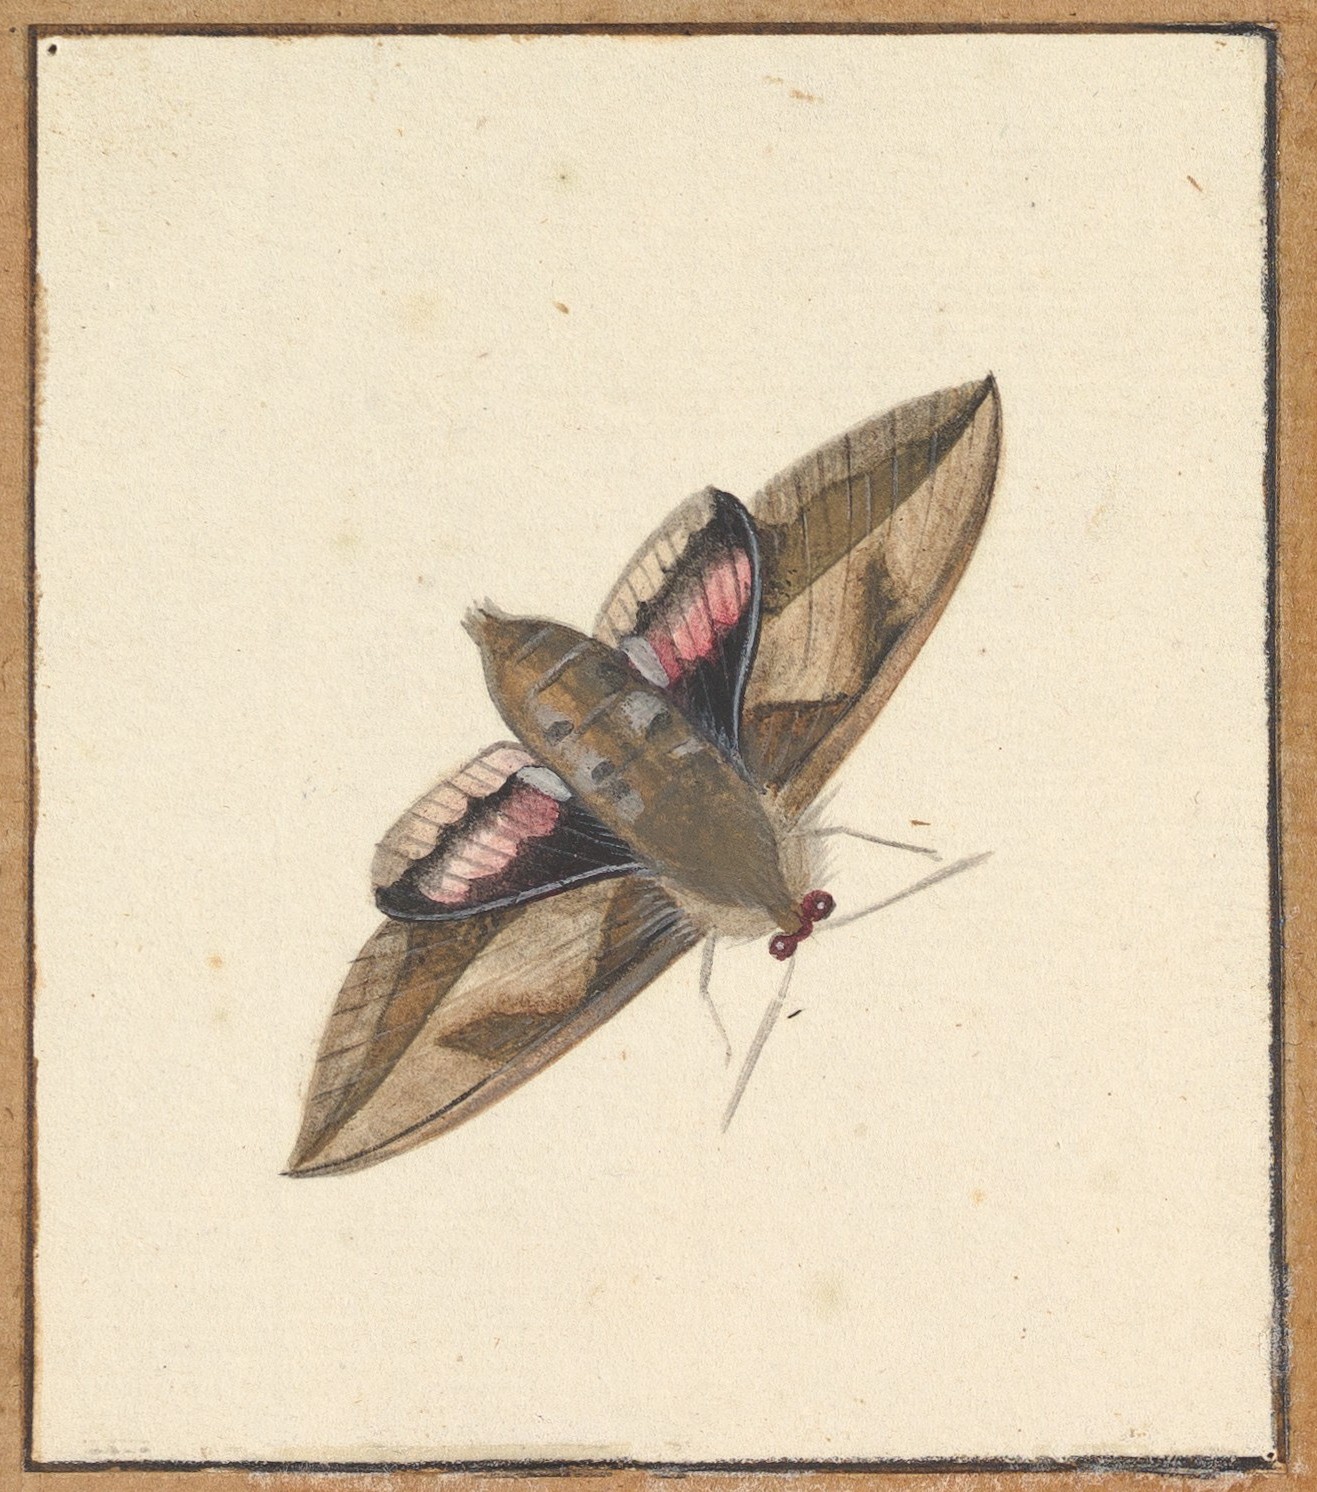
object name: drawing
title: A Moth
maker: nicolaas struyk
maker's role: artist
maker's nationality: dutch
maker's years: 1686-1769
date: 1701-1766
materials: graphite, ink, watercolor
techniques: pen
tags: insects